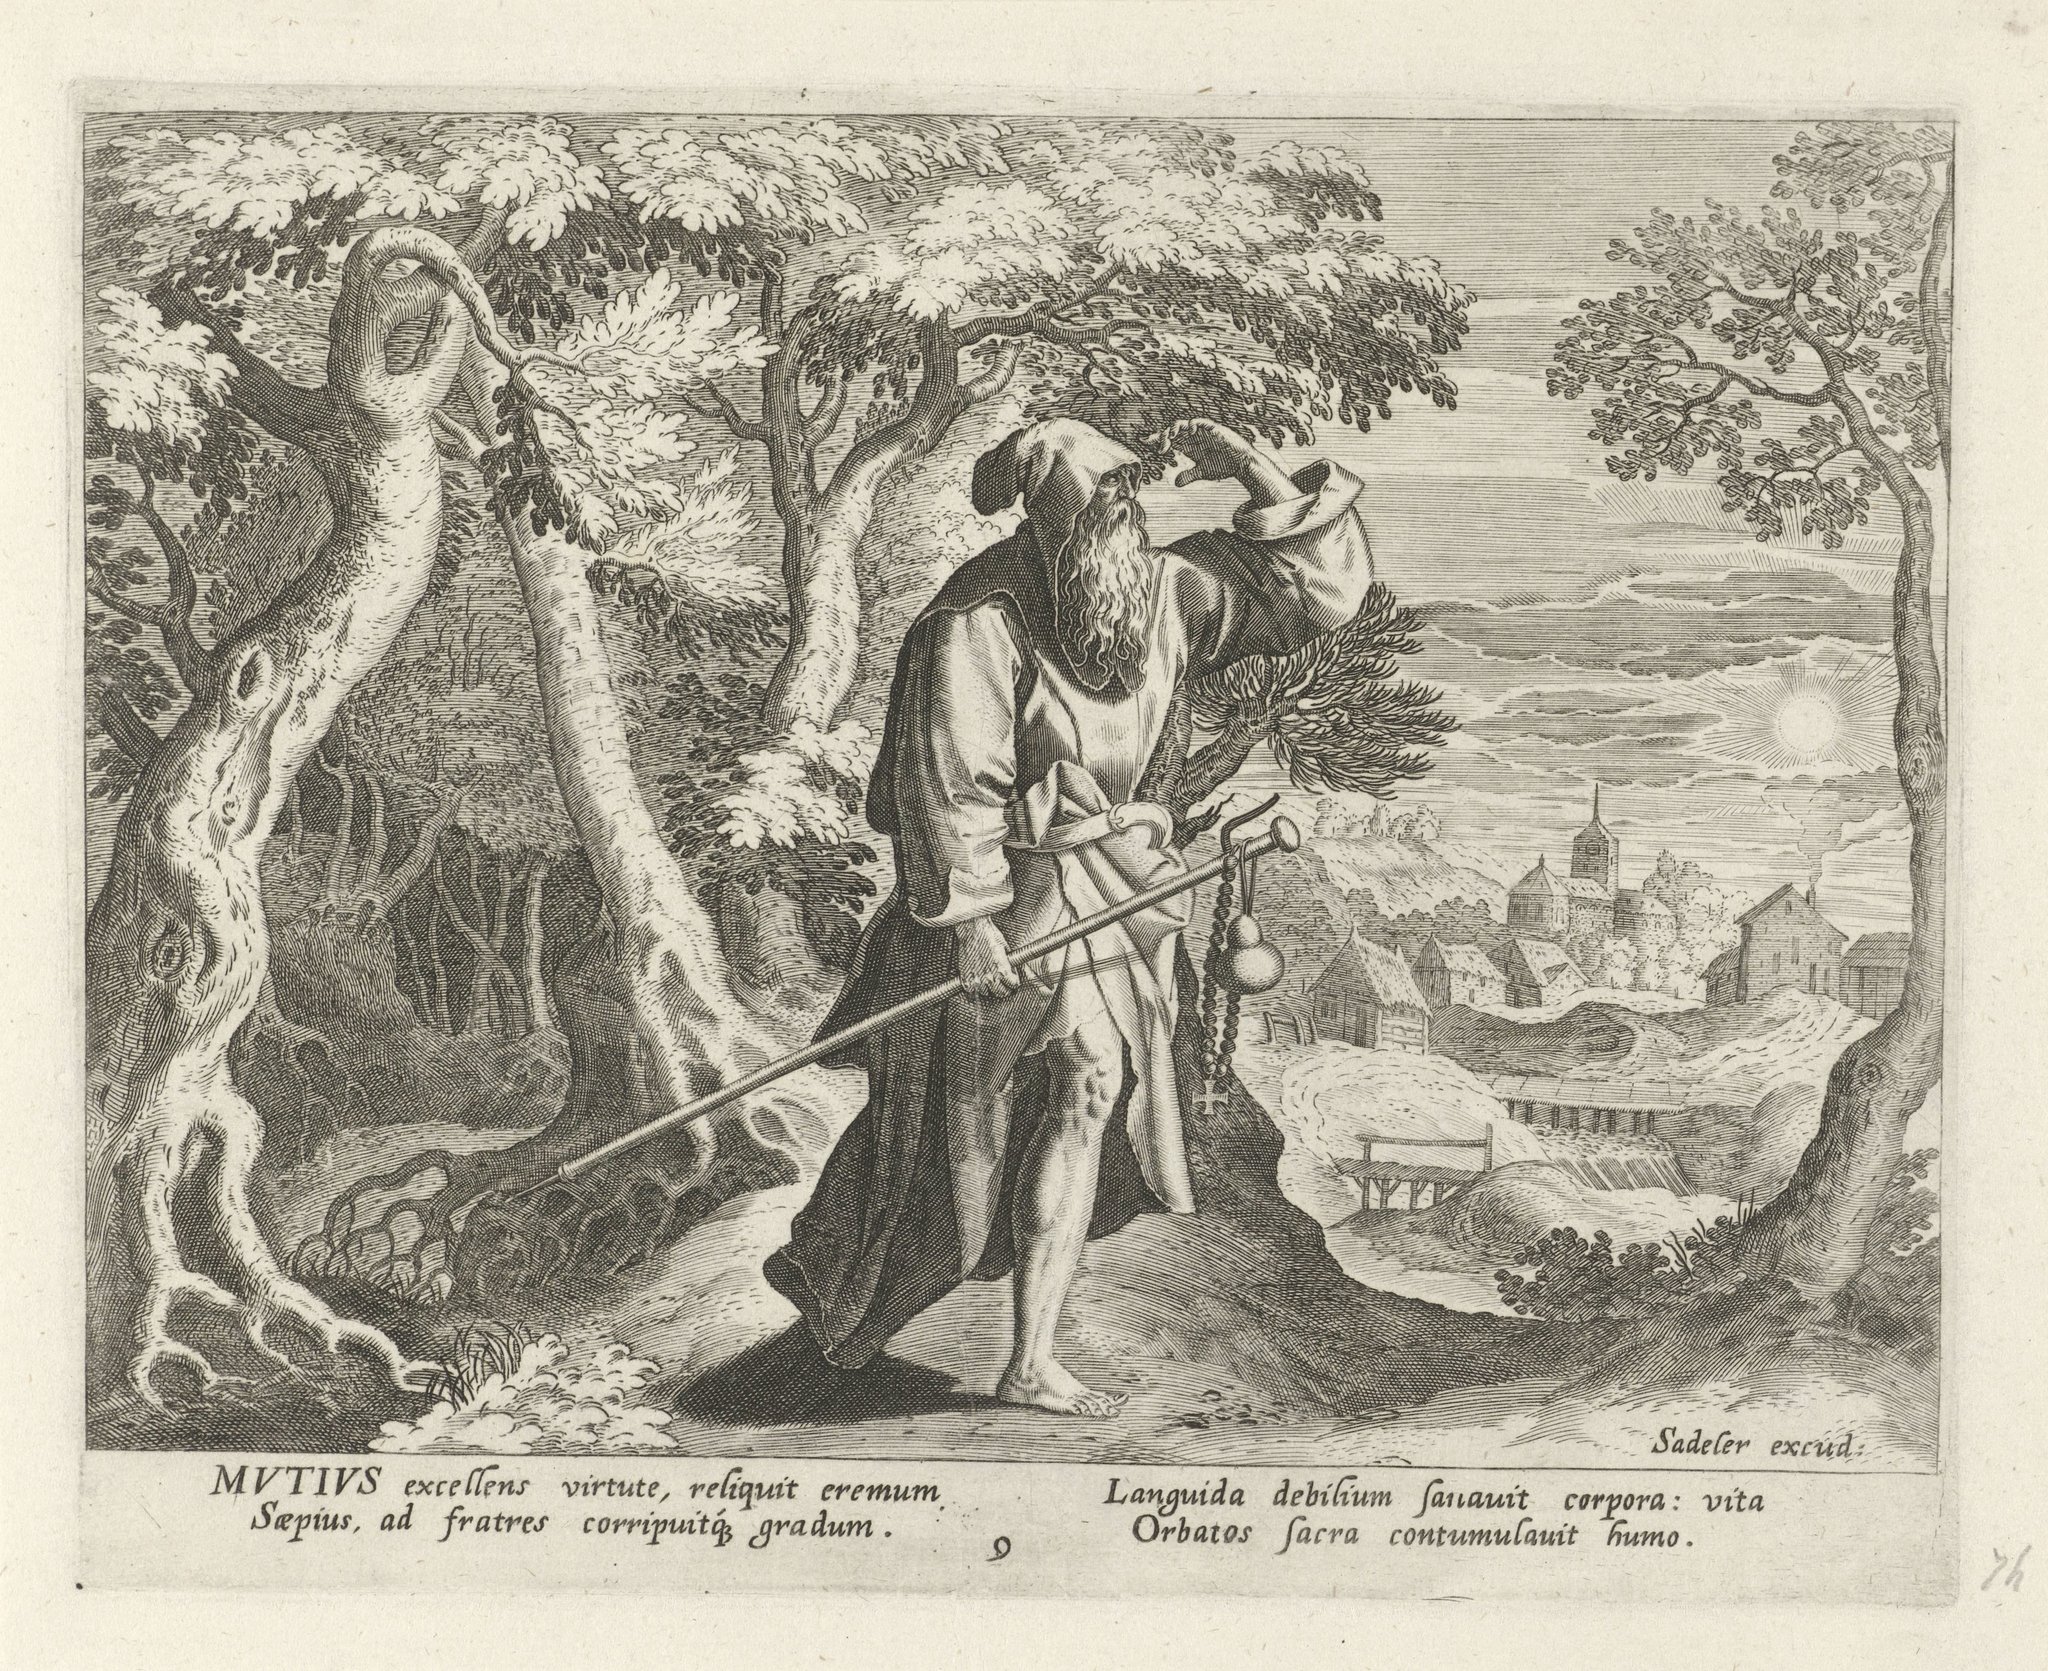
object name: print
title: Solitudo Sive Vitae Patrum Eremicolarum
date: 1583-1588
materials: paper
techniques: engraving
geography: antwerp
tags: saints, anchorite, hermit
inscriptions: collector's mark: Lugt 2228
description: Mutius, een vroeg-christelijke kluizenaar, in een bos. In zijn handen een kluizenaarsstaf. Op de achtergrond een dorp met een beekje.